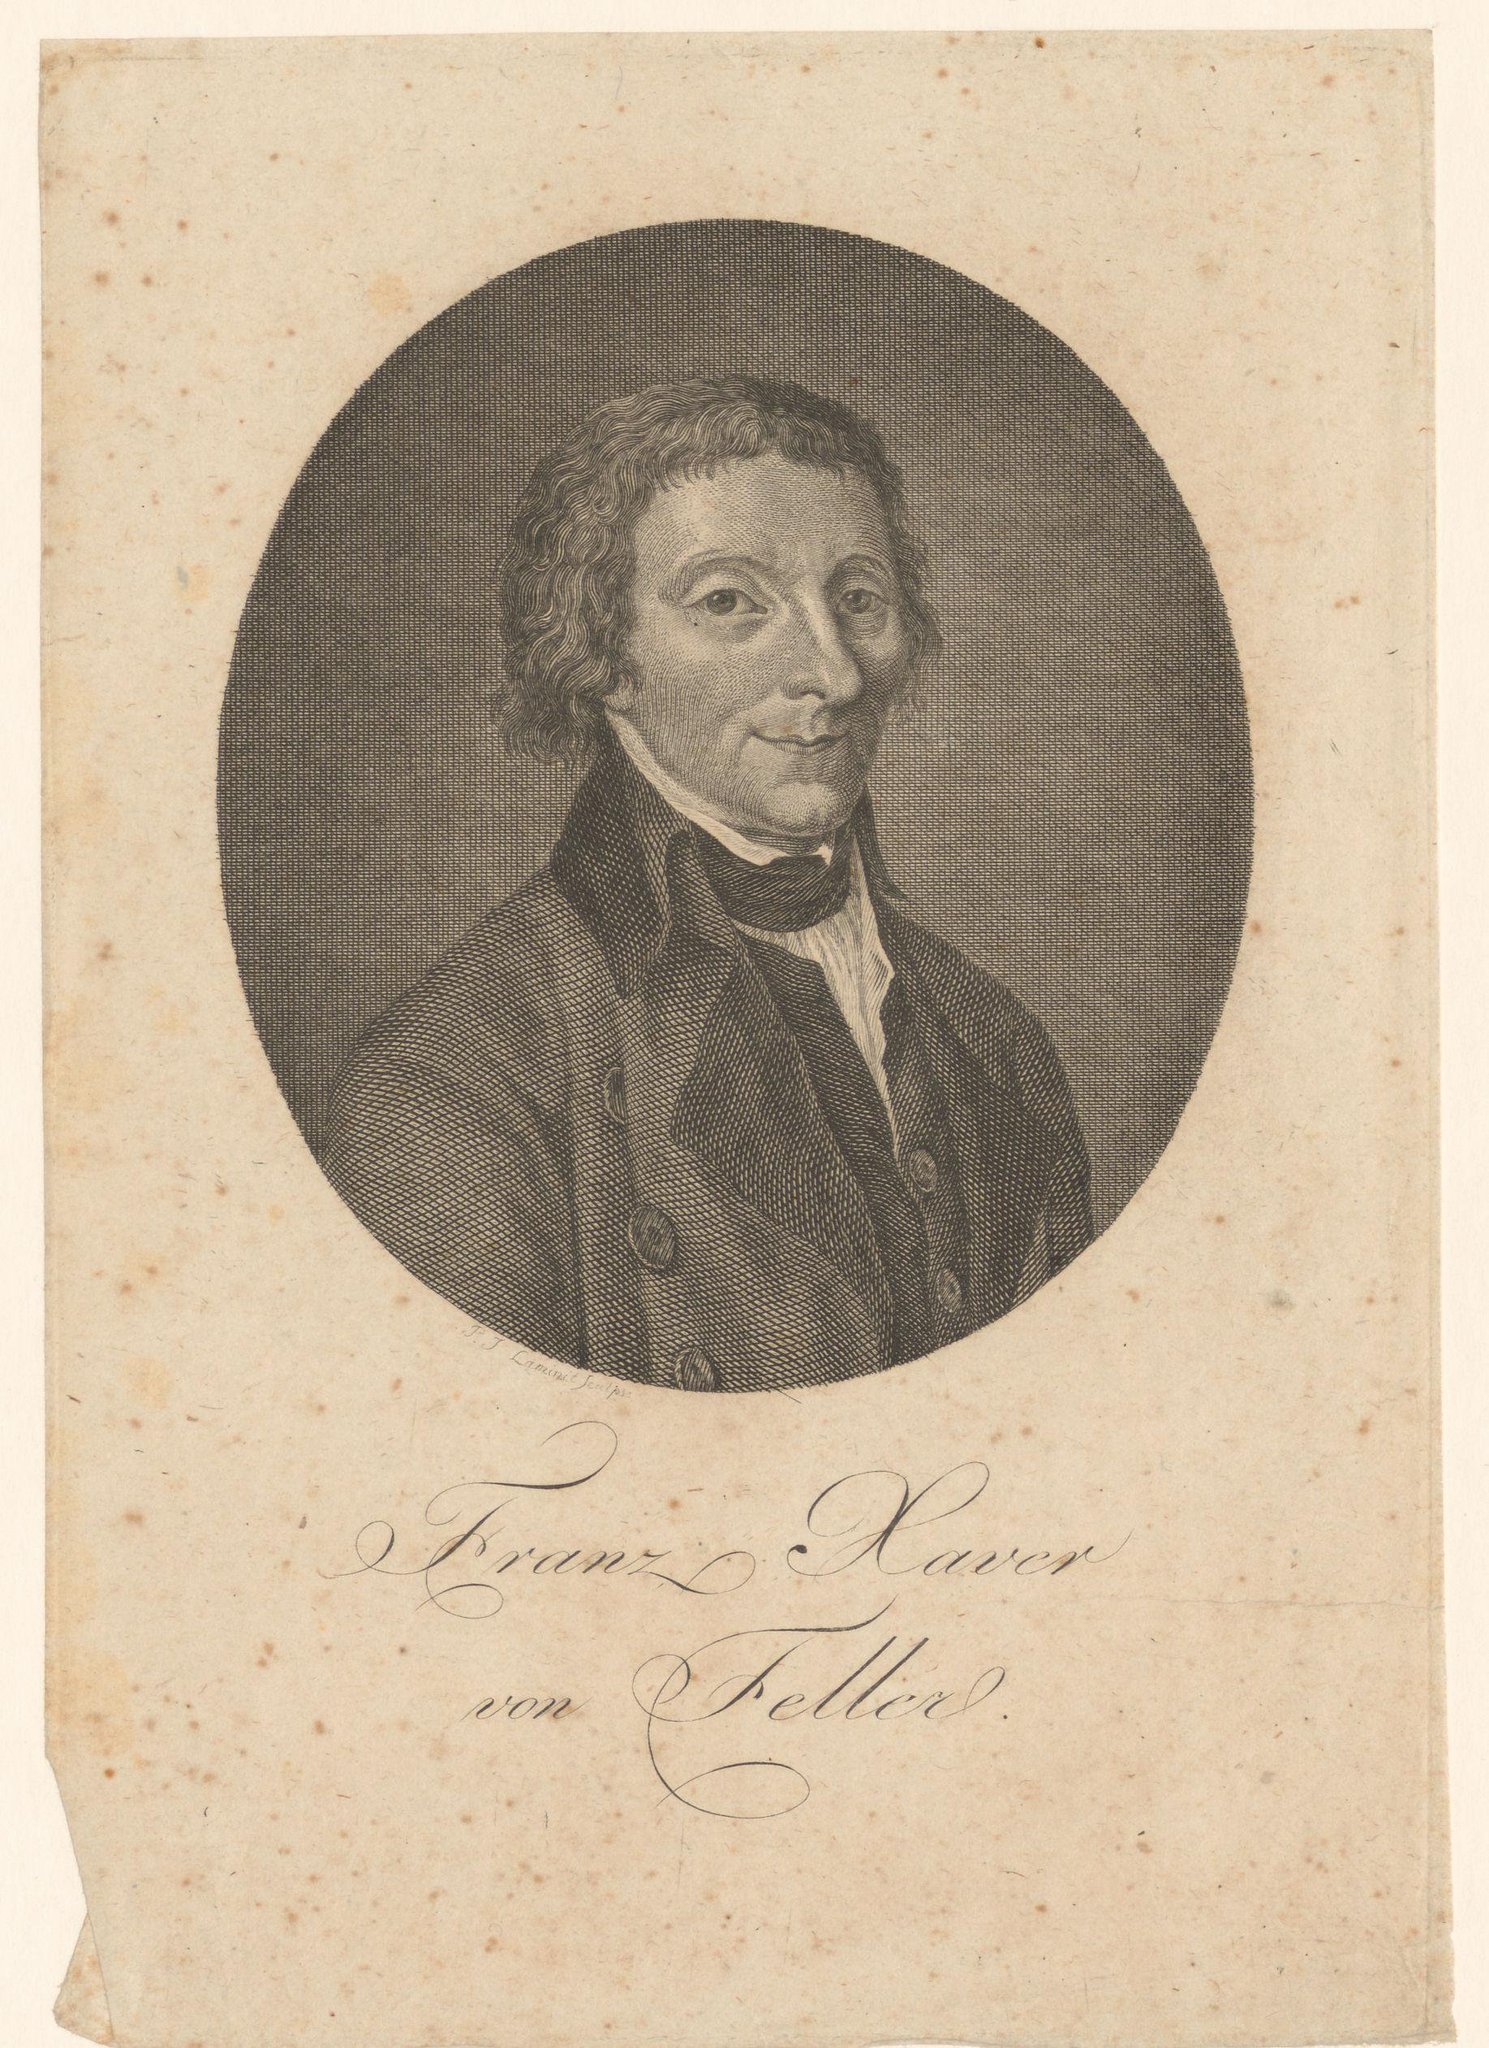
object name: print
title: Portret van Franz Xaver von Feller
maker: paul jacob laminit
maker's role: print maker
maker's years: 1773-1831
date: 1783-1831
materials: paper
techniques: engraving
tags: theologian, historical persons, portrait of a writer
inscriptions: collector's mark: Lugt 2228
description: Een facsimile signatuur in de ondermarge.